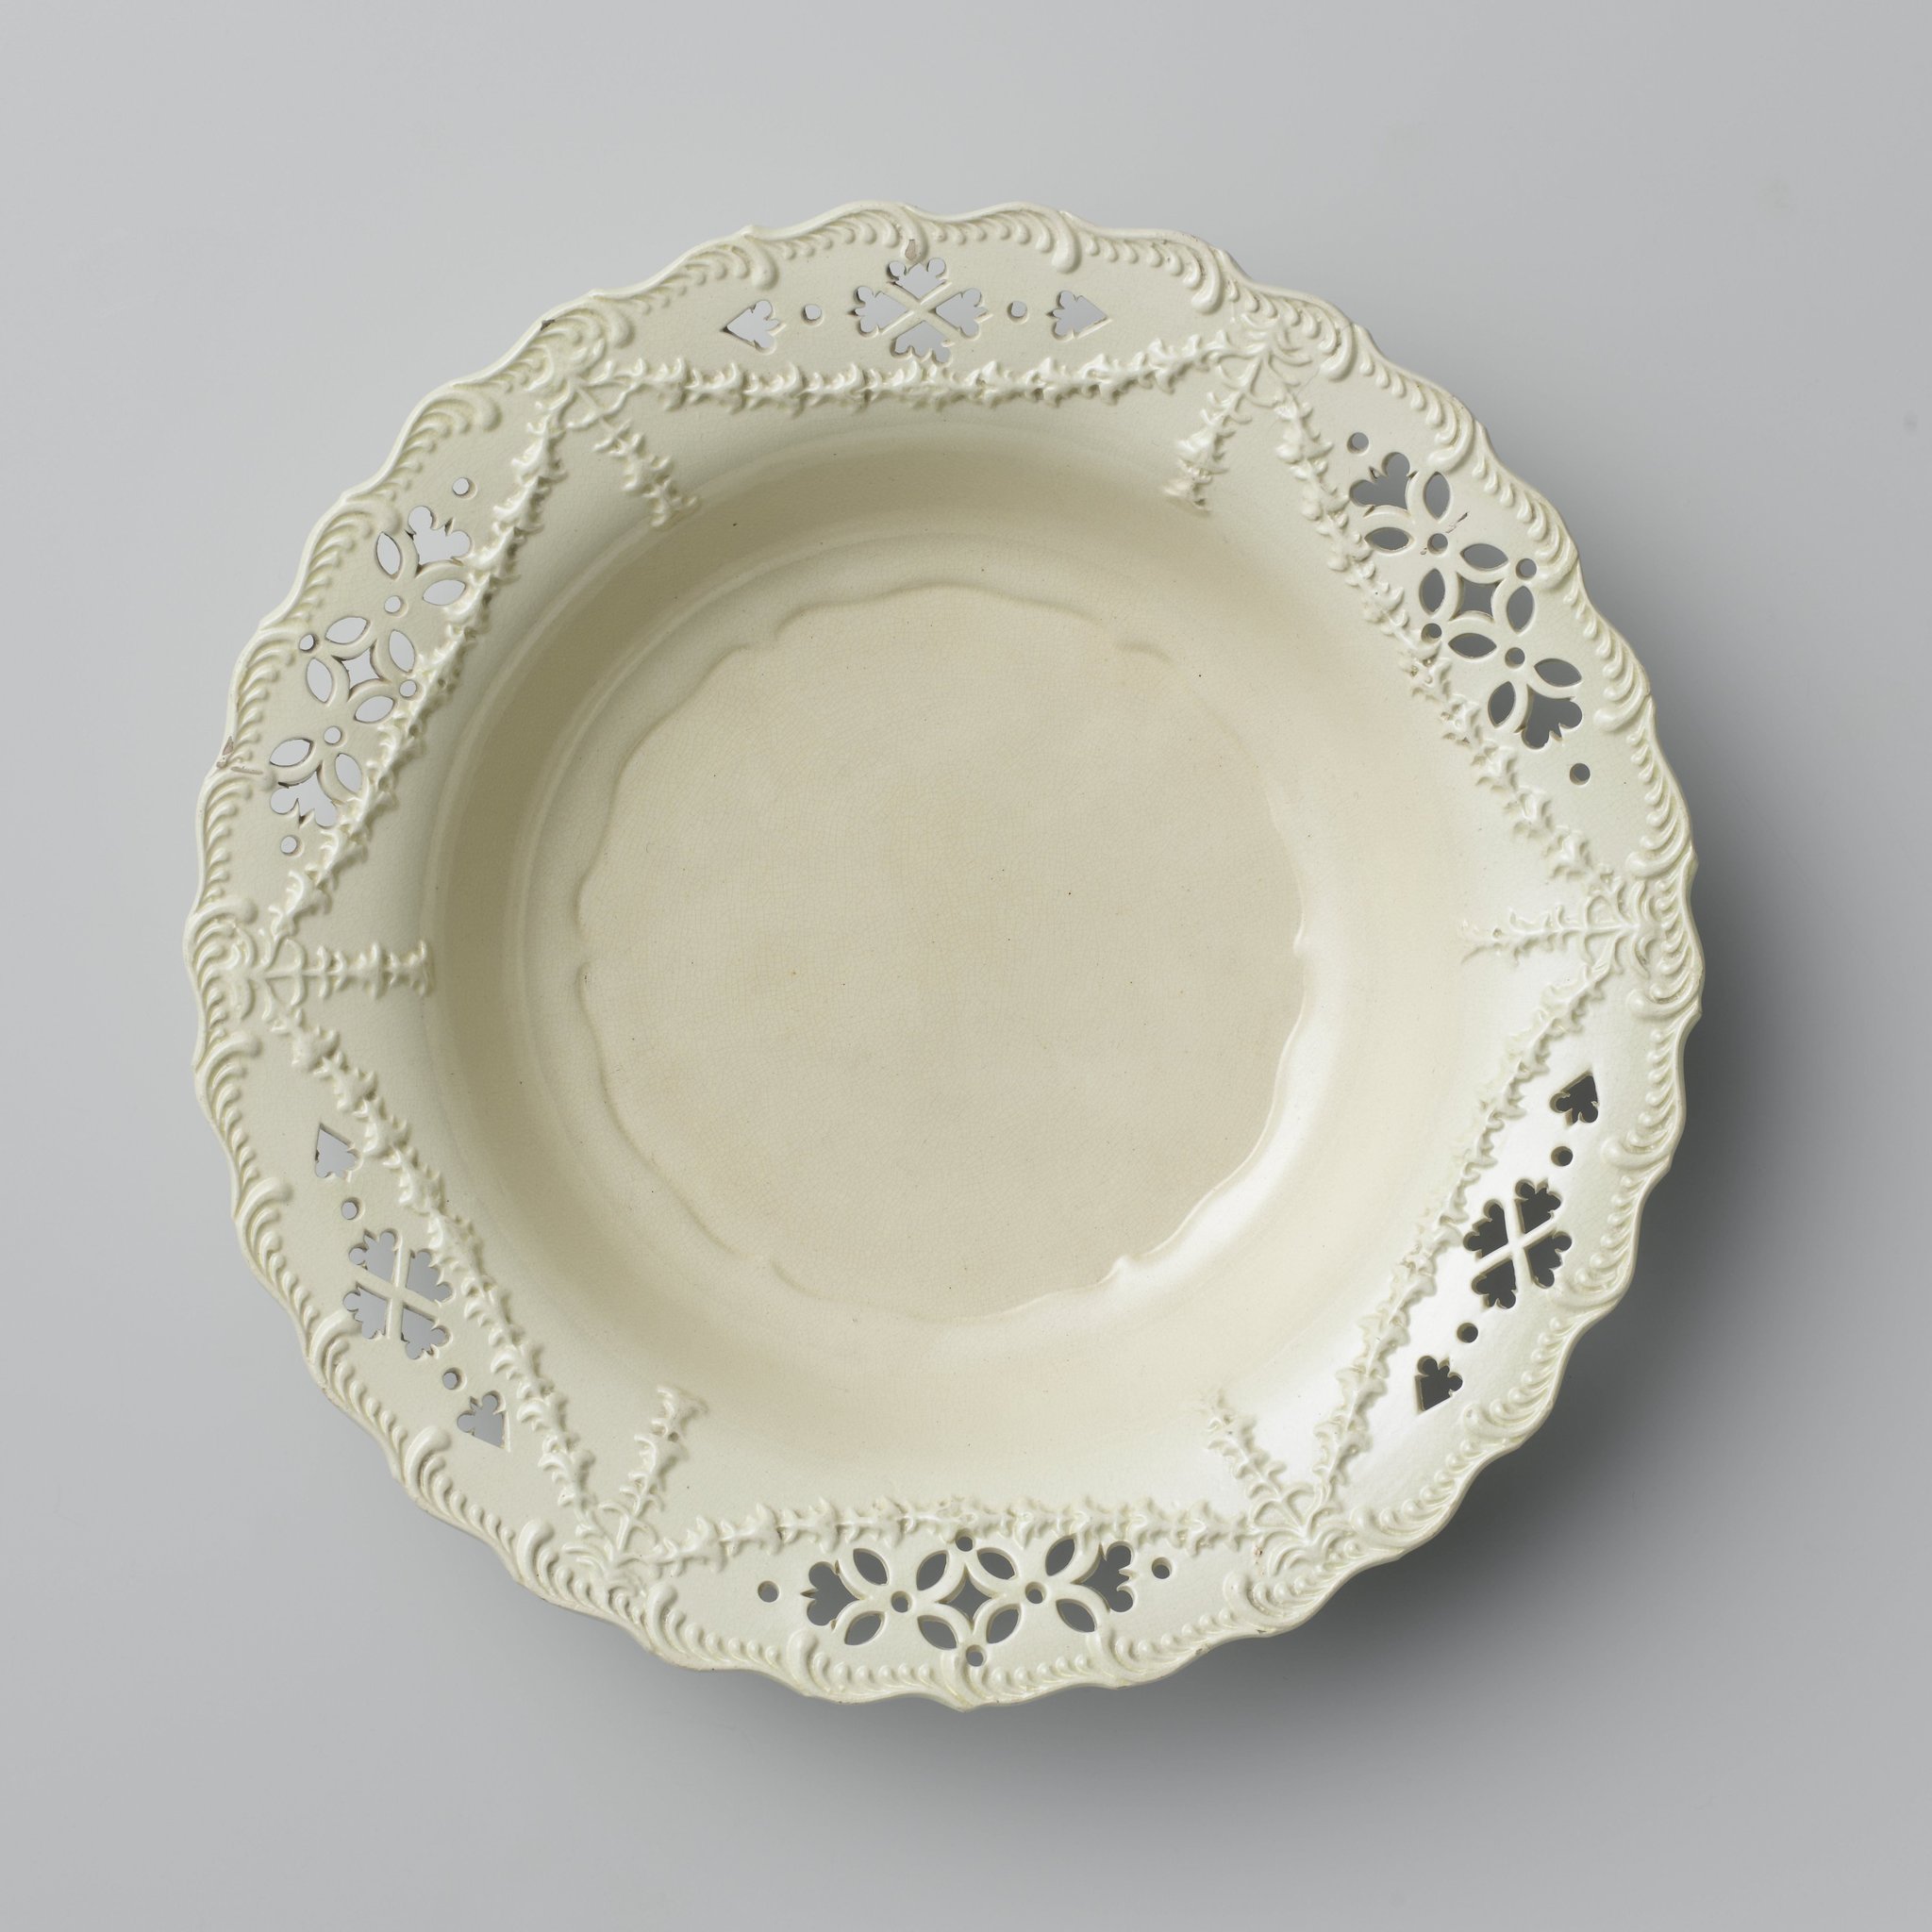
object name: plate dish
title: Bord van hardgebakken aardewerk, Leeds creamware met opengewerkte rand.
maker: Anonymous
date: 1780-1800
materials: earthenware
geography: leeds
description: Rond bord van hardgebakken aardewerk. De rand is gegolfd en heeft zes opengewerkte velden, waaromheen guirlandes en festoenen in reliëf.